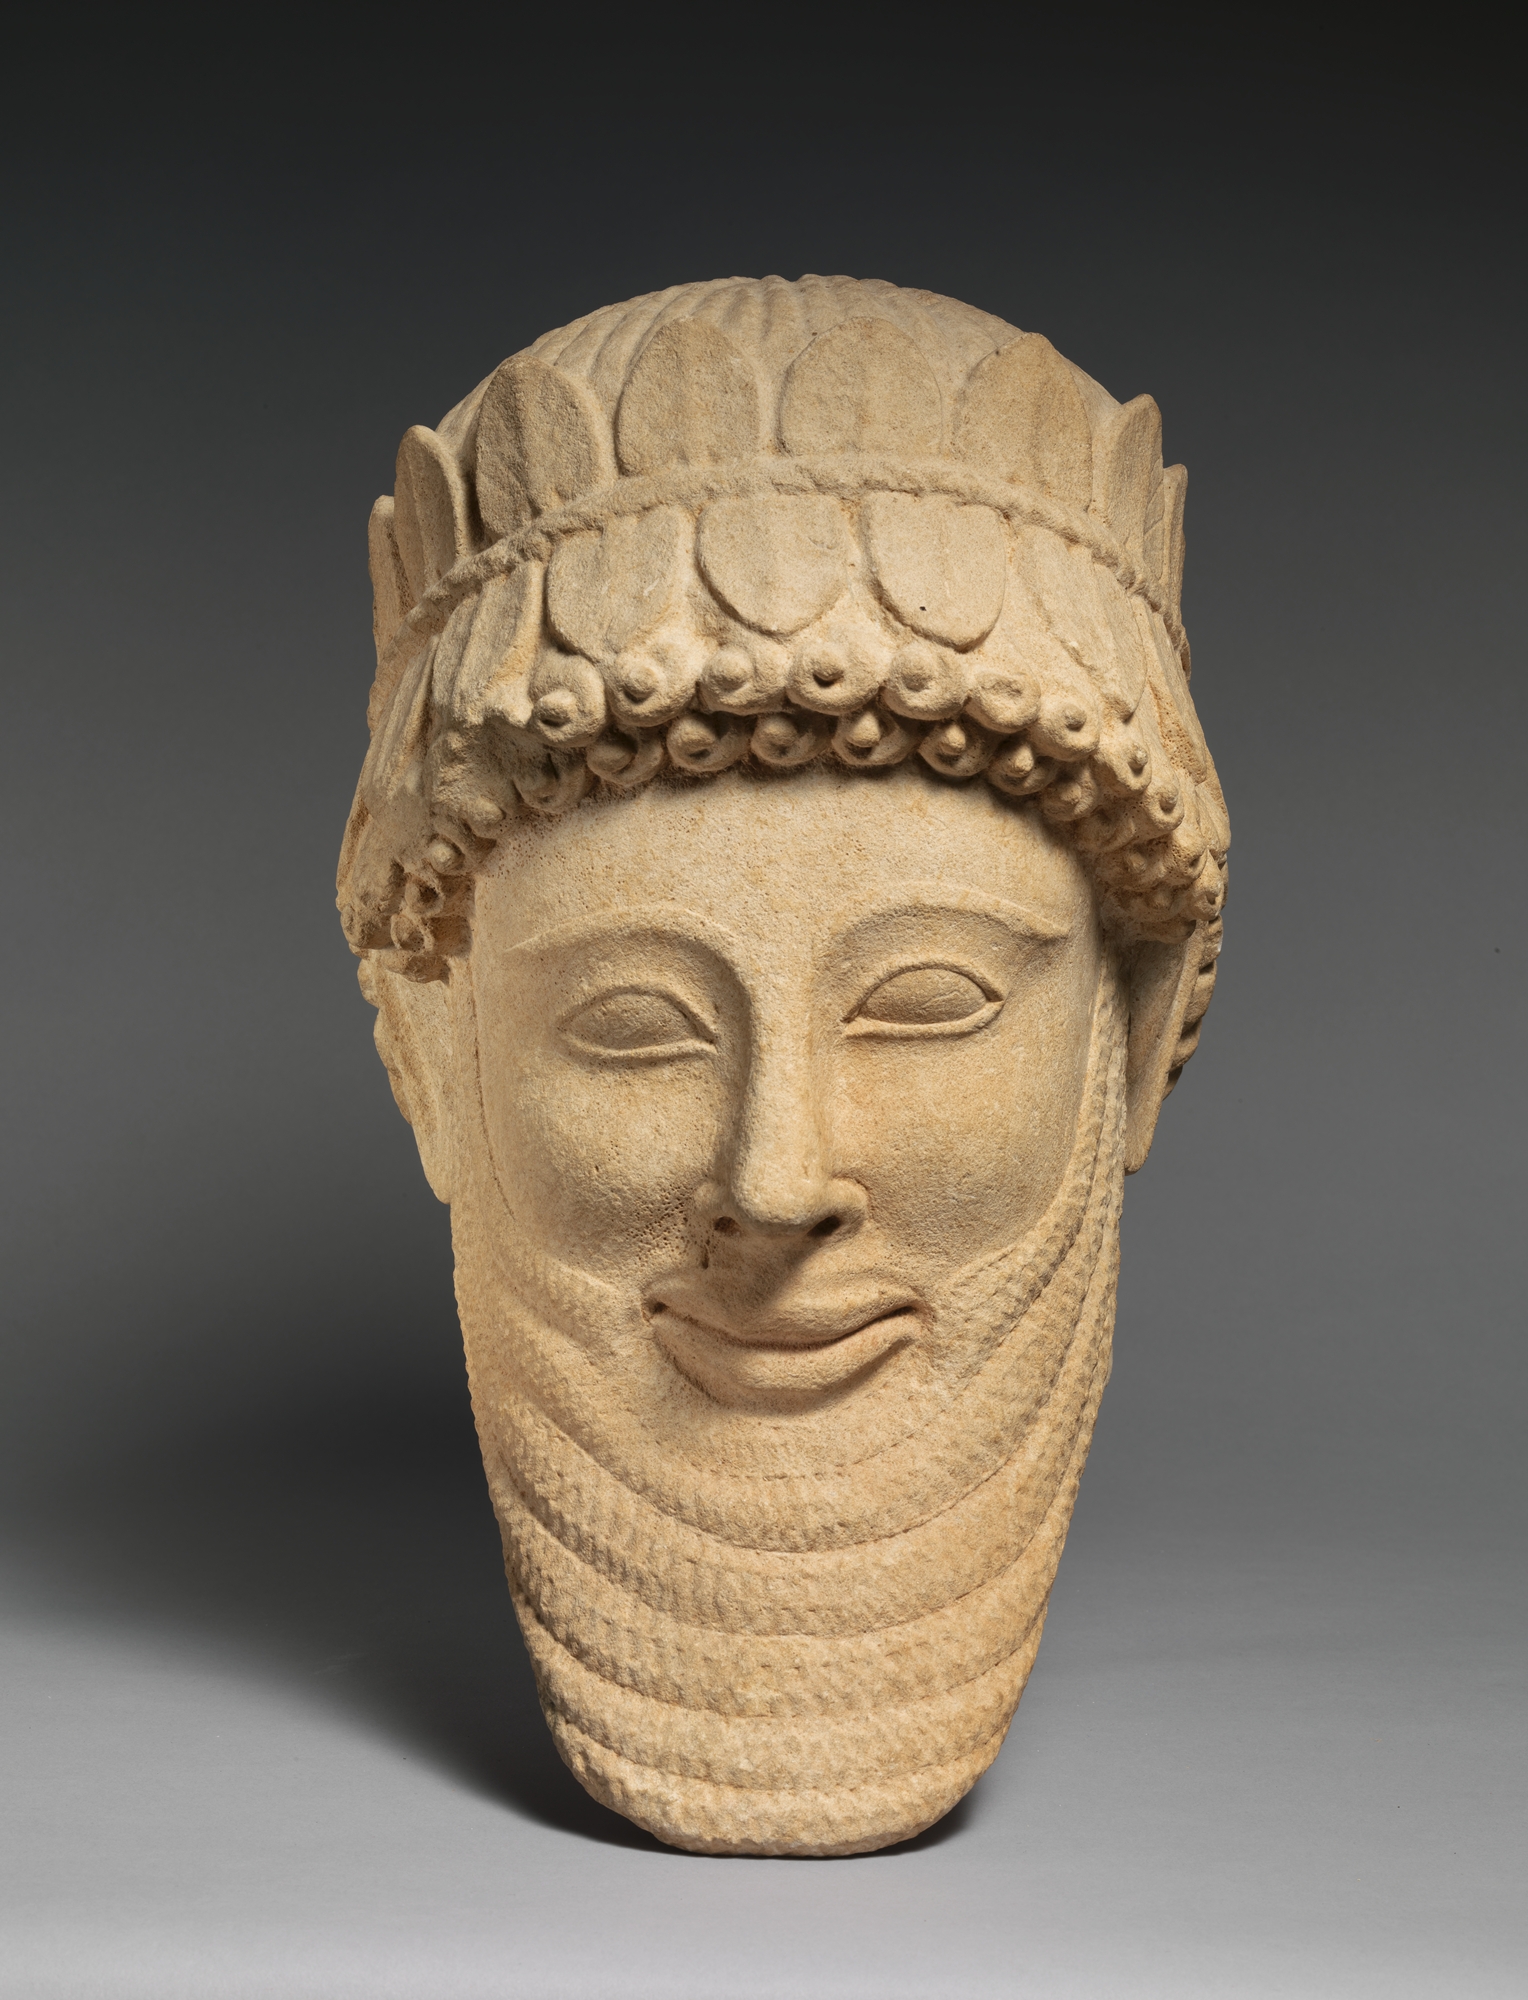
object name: head of a man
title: Limestone head of a man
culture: cypriot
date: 500-468 BCE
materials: limestone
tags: heads,men,leaves